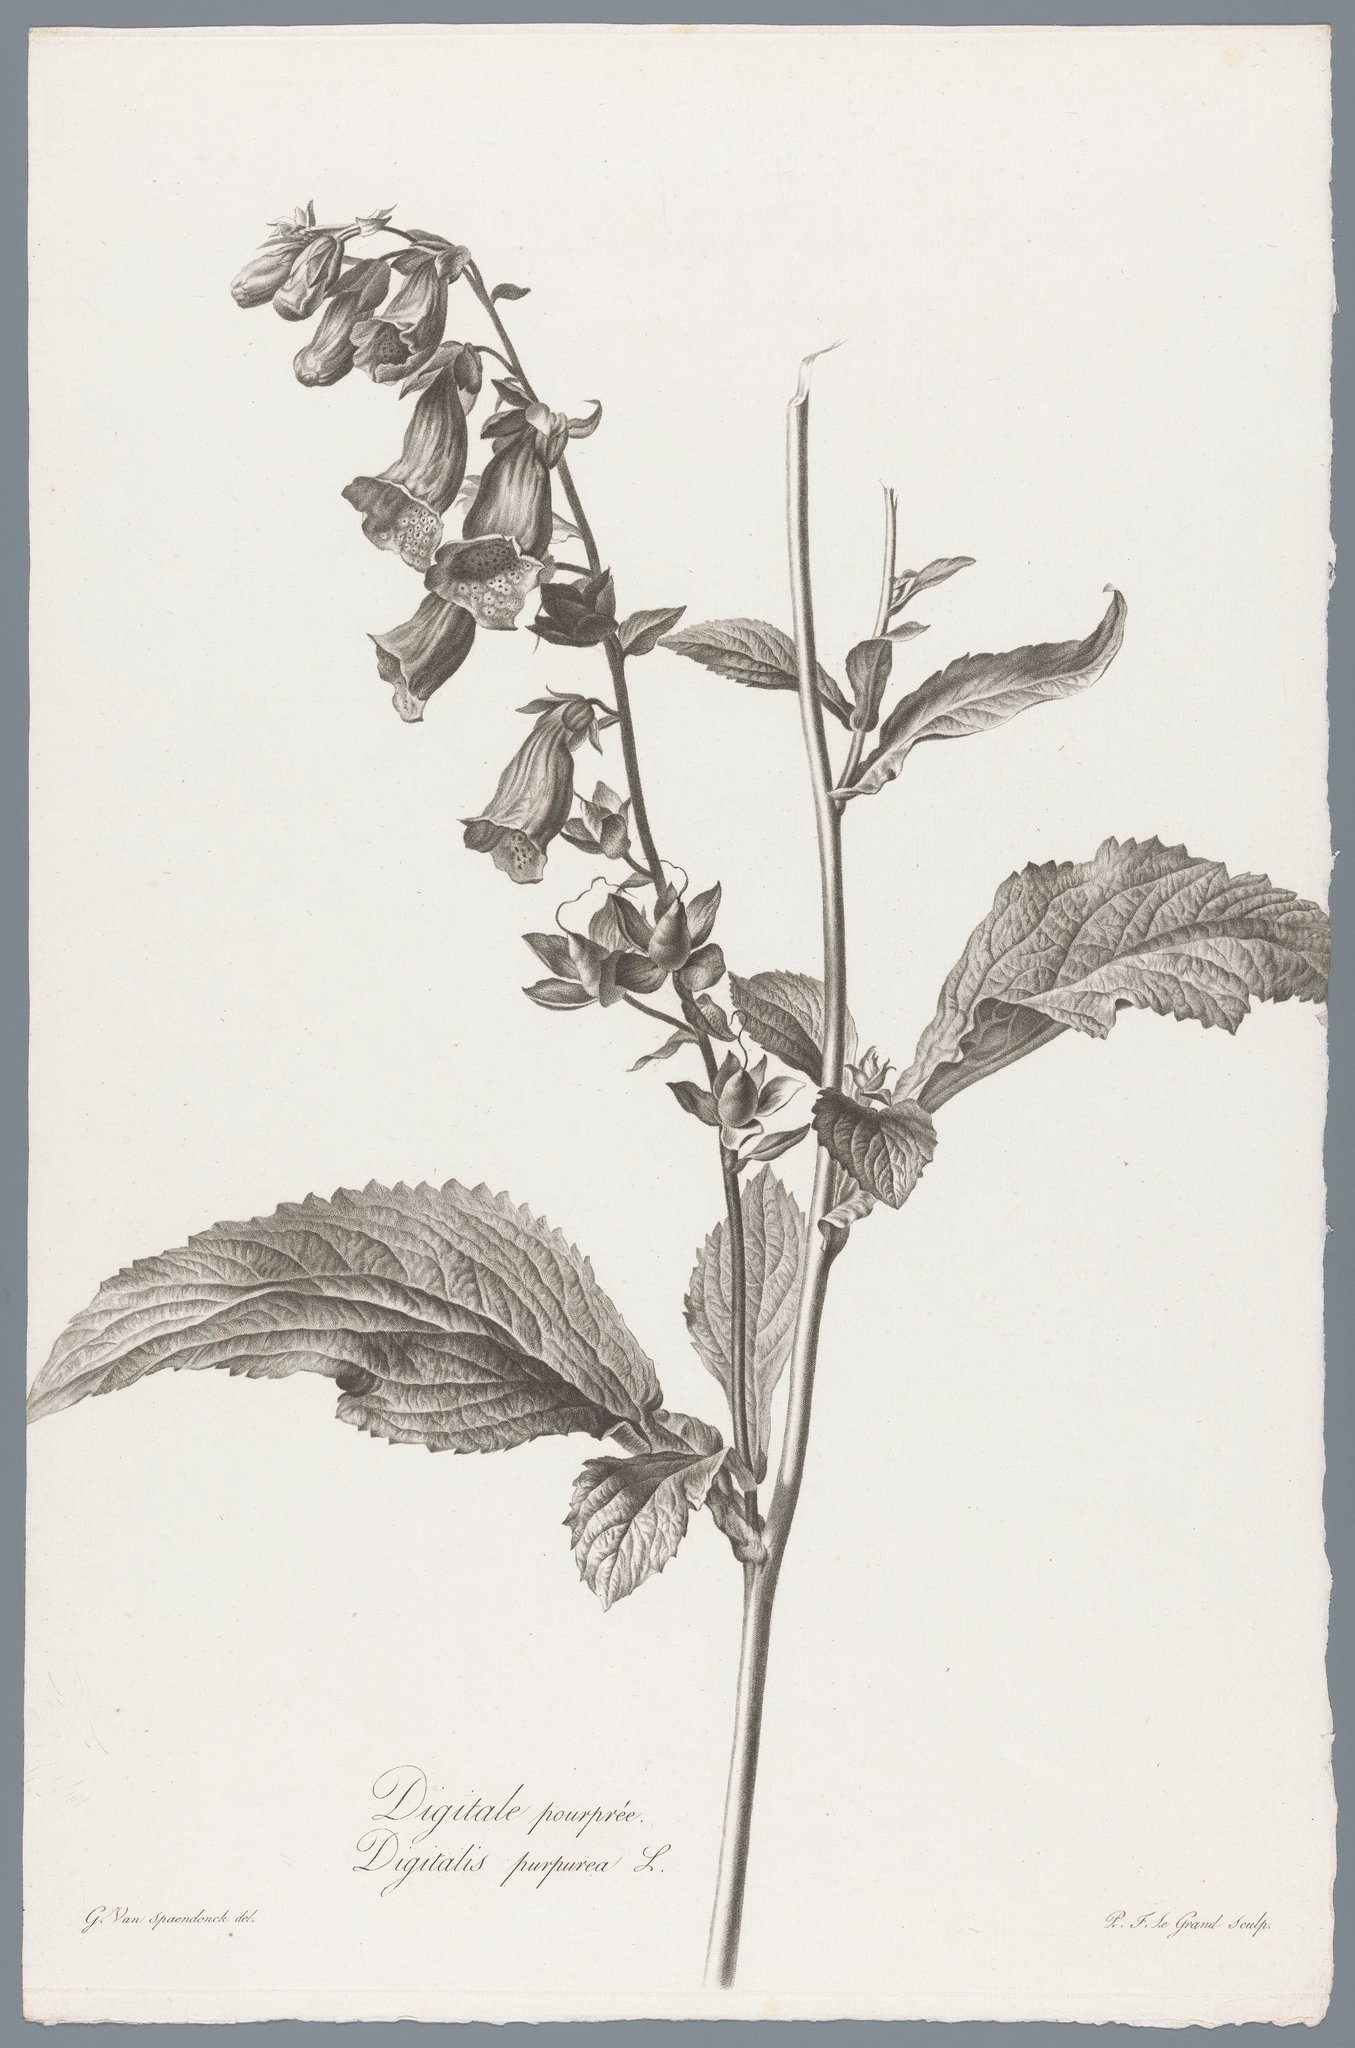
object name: ornament print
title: Fleurs dessinées d'après nature (...)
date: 1799-1801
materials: paper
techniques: engraving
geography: paris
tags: flowers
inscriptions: collector's mark: Lugt 2228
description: De serie Fleurs dessinées d'après nature (...) bestaat uit 24 prenten verdeeld over zes omslagen. Het Rijksprentenkabinet heeft 23 prenten in zes omslagen in bezit. De verdeling over de omslagen lijkt willekeurig. Zie RP-P-1909-4220 t/m 4242 en RP-P-2016-53 t/m 58.